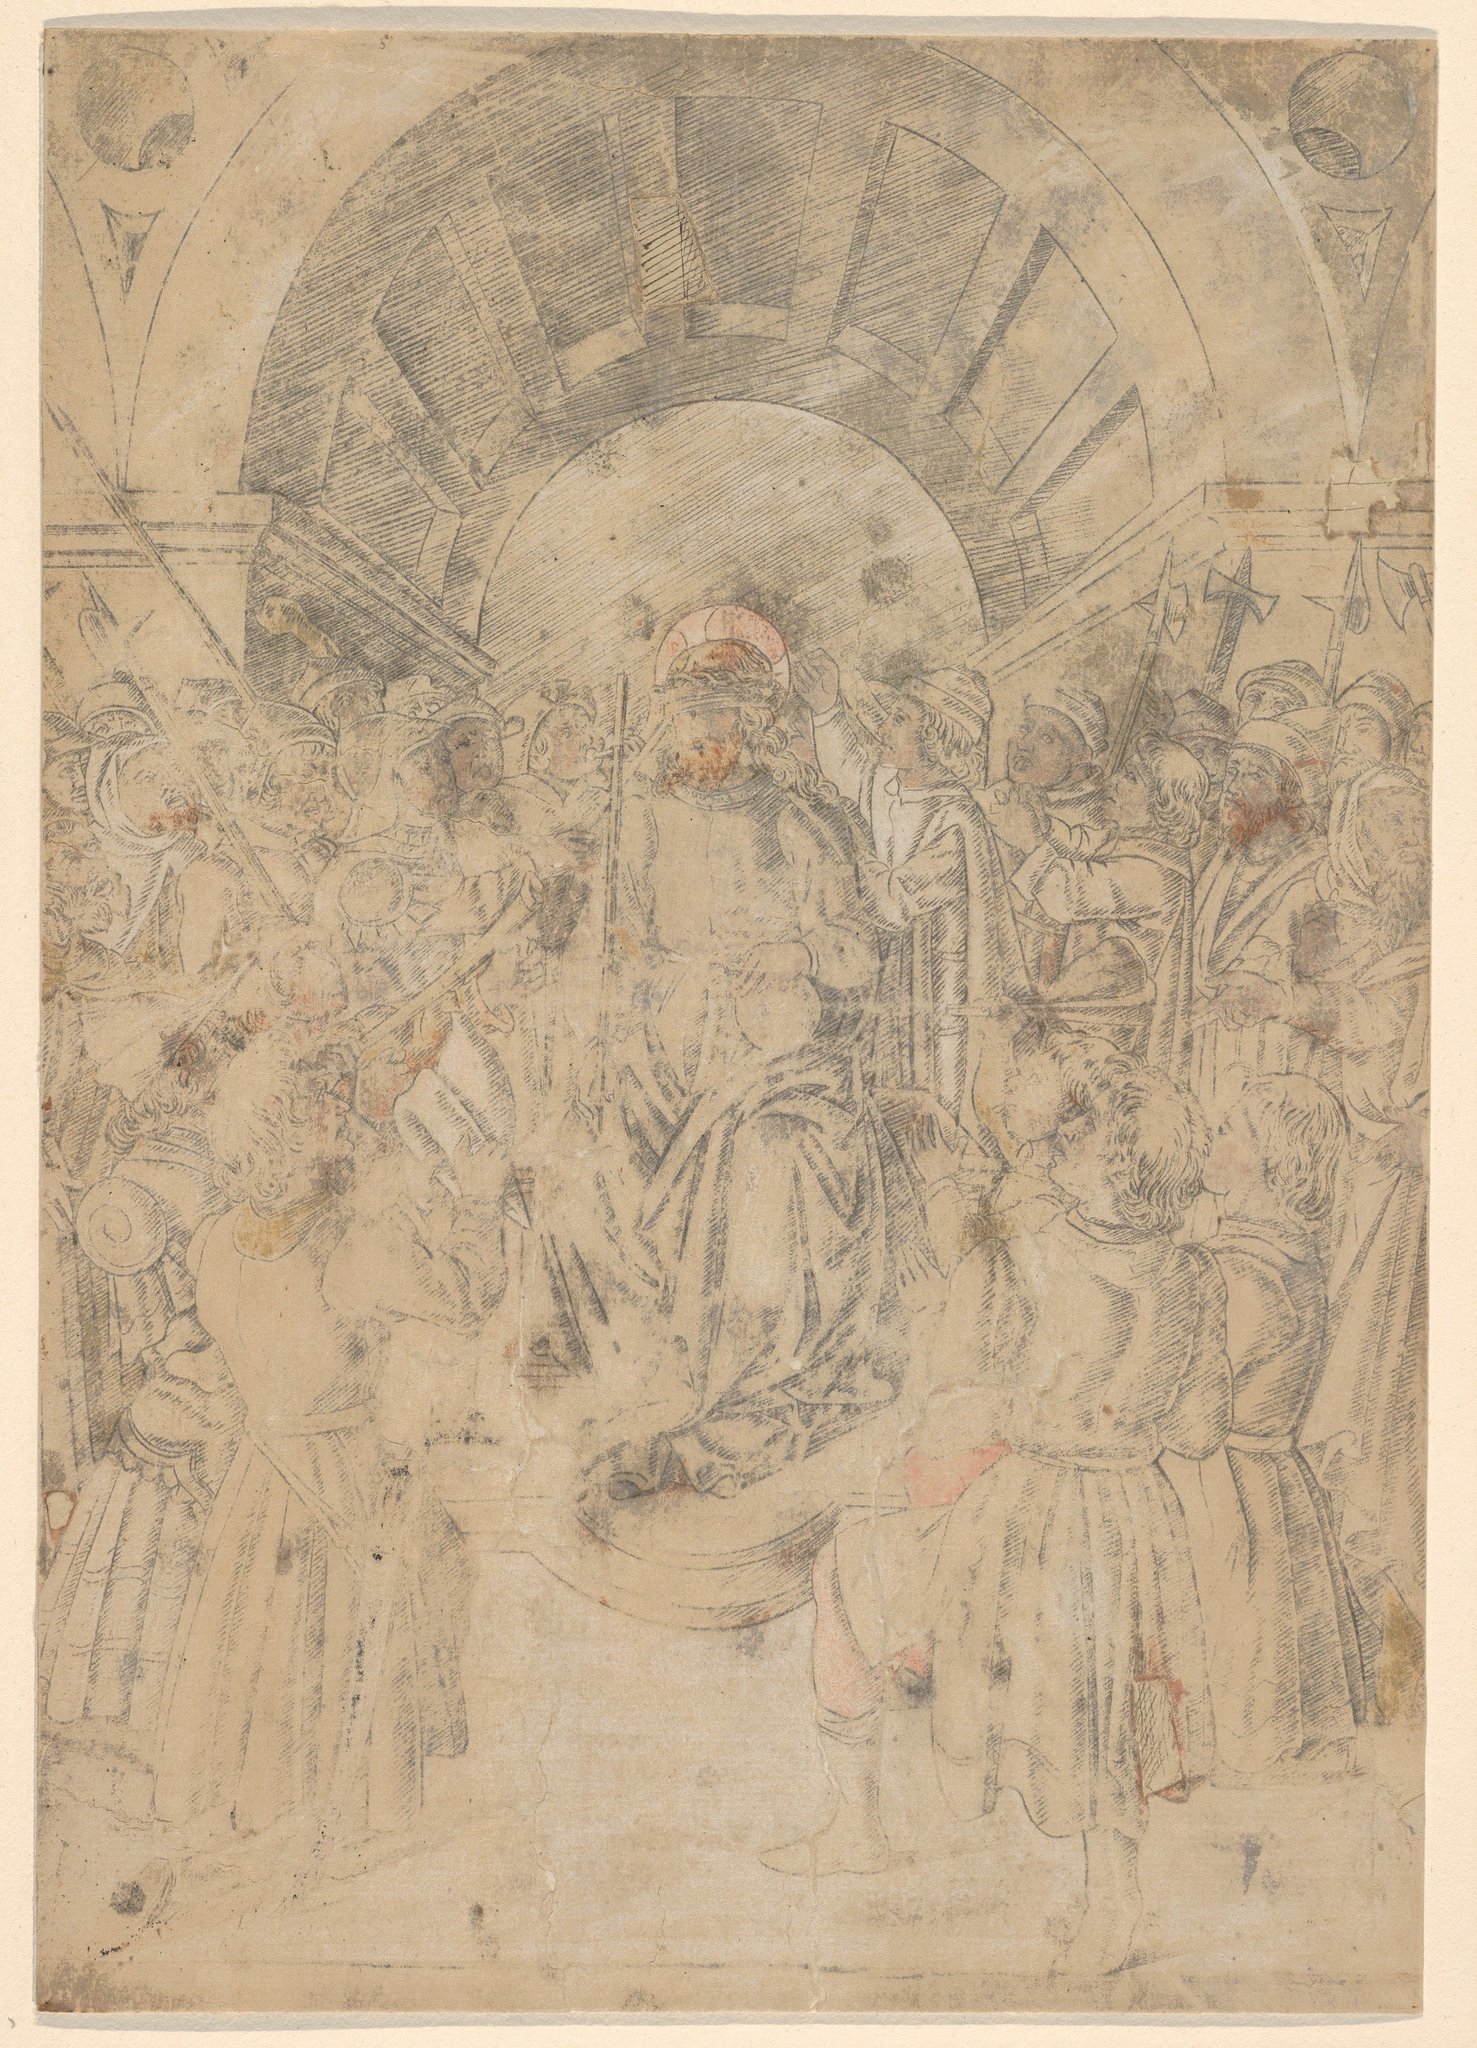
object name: print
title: The Mocking of Christ, from "Life of the Virgin and Christ"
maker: francesco rosselli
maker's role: artist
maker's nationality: italian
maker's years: 1448-1527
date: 1480-1500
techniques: engraving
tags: christ,crowd